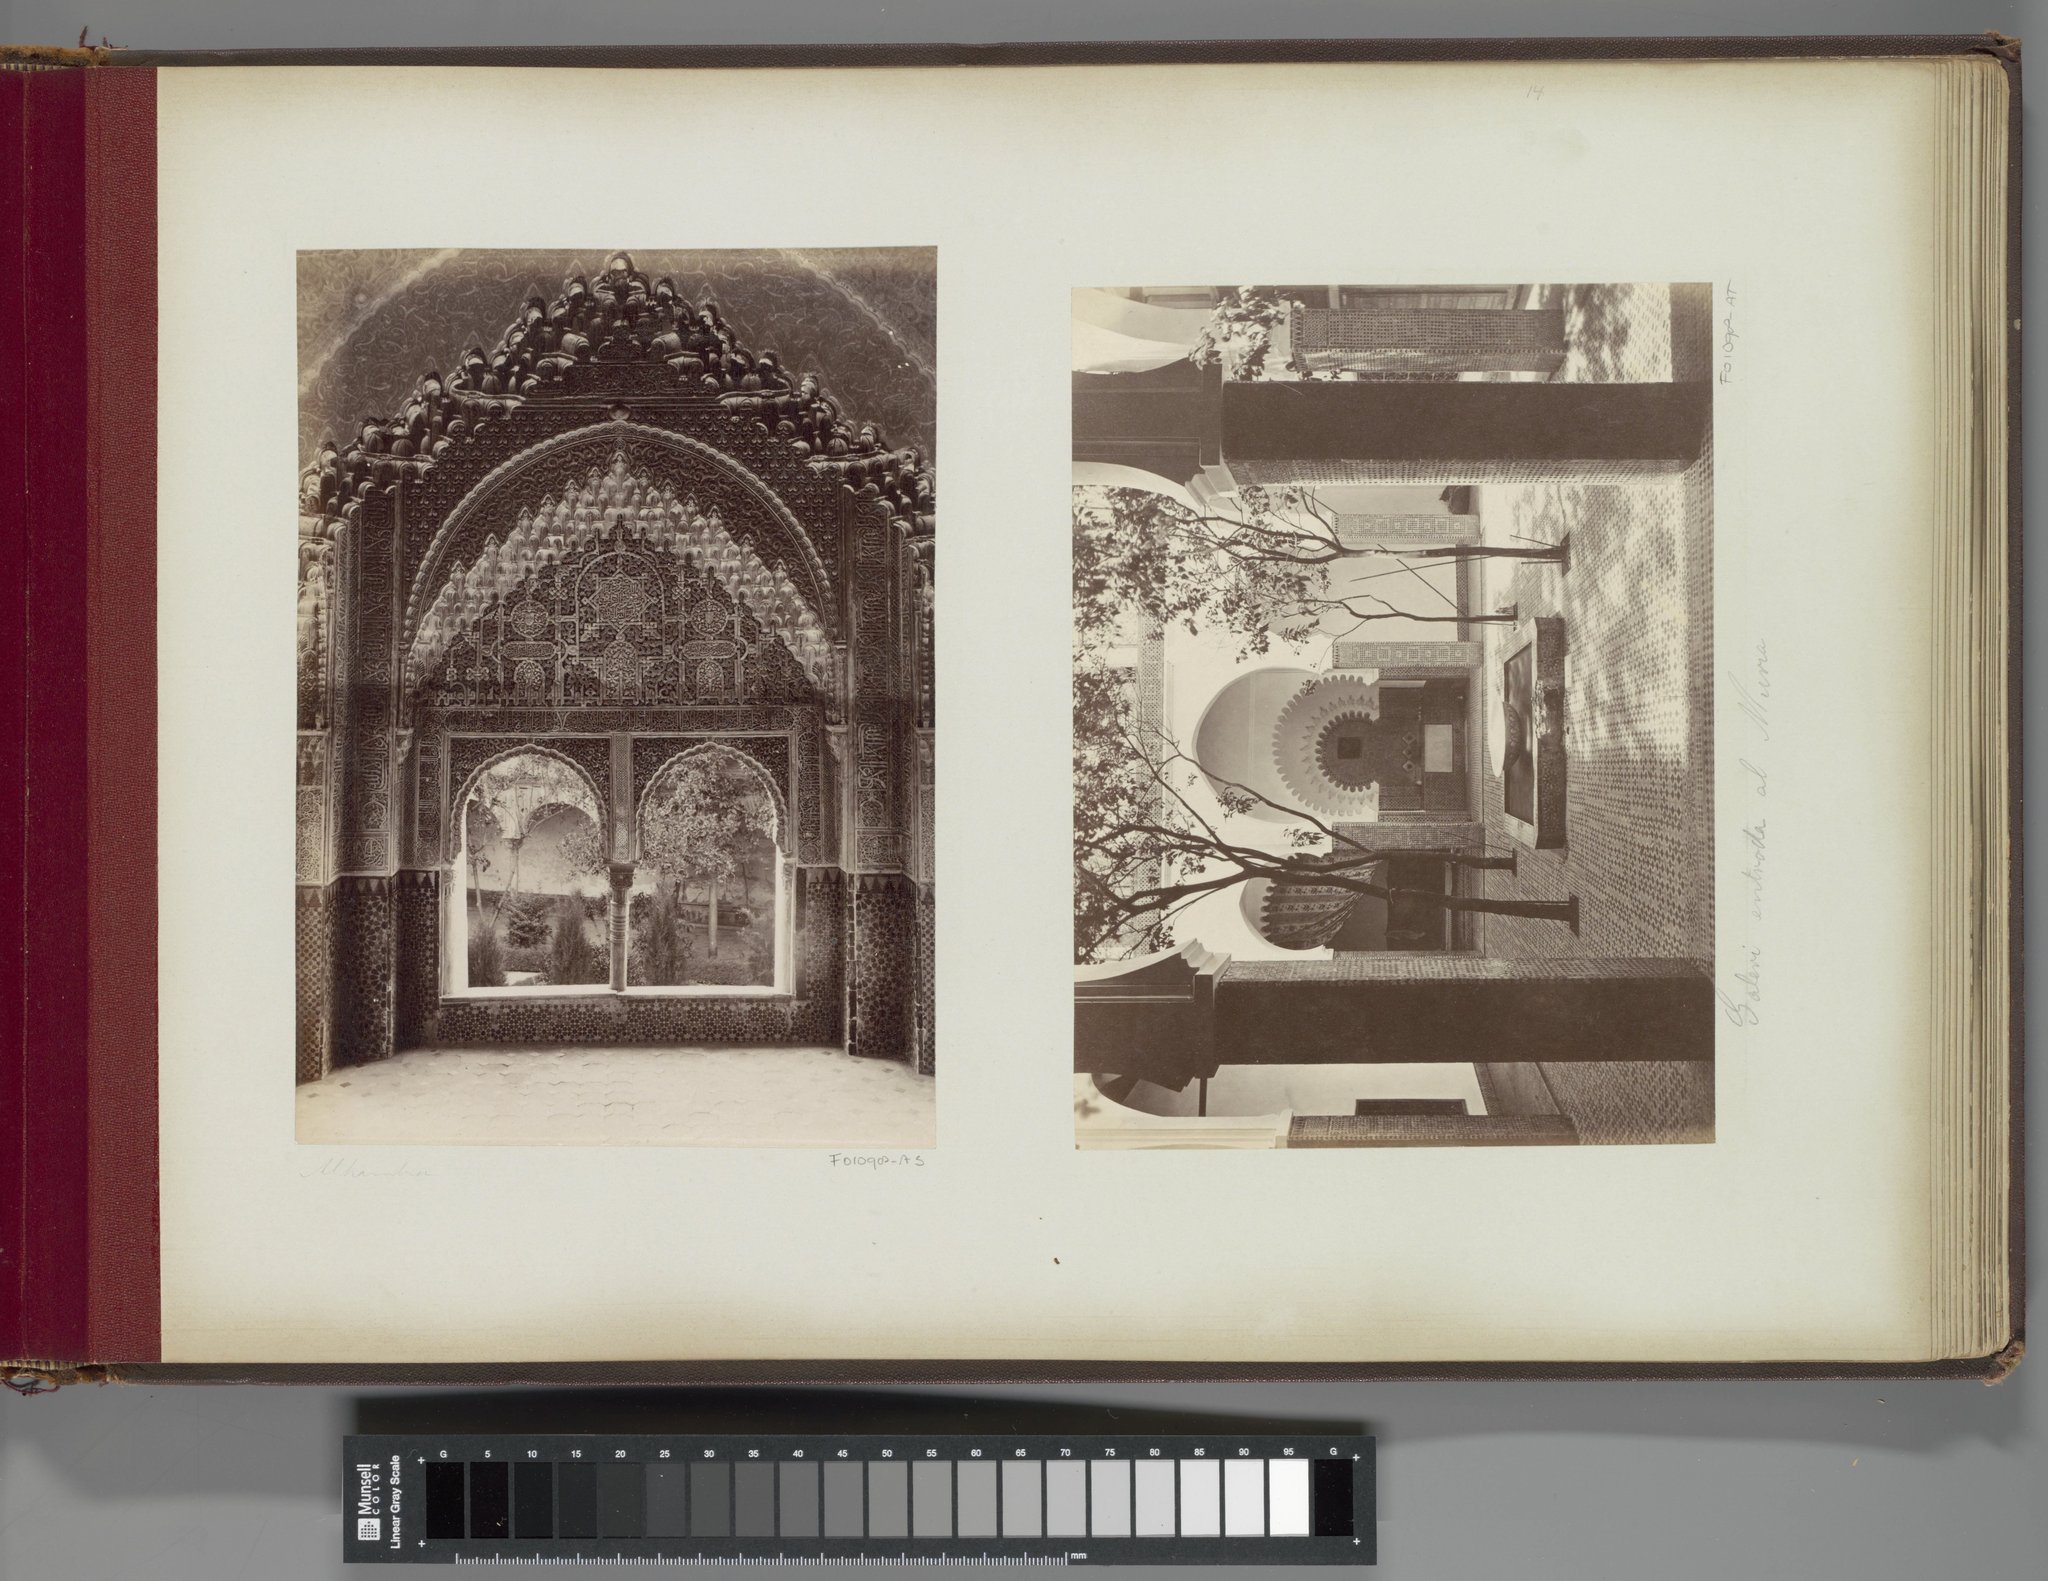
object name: photograph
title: Interieur met bewerkte bogen van het Alhambra in Granada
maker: Anonymous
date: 1860-1880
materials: cardboard, paper, photographic support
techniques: albumen print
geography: alhambra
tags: palace, arcade ~ architecture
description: Onderdeel van Reisalbum met foto's van bezienswaardigheden in Spanje en Marokko.